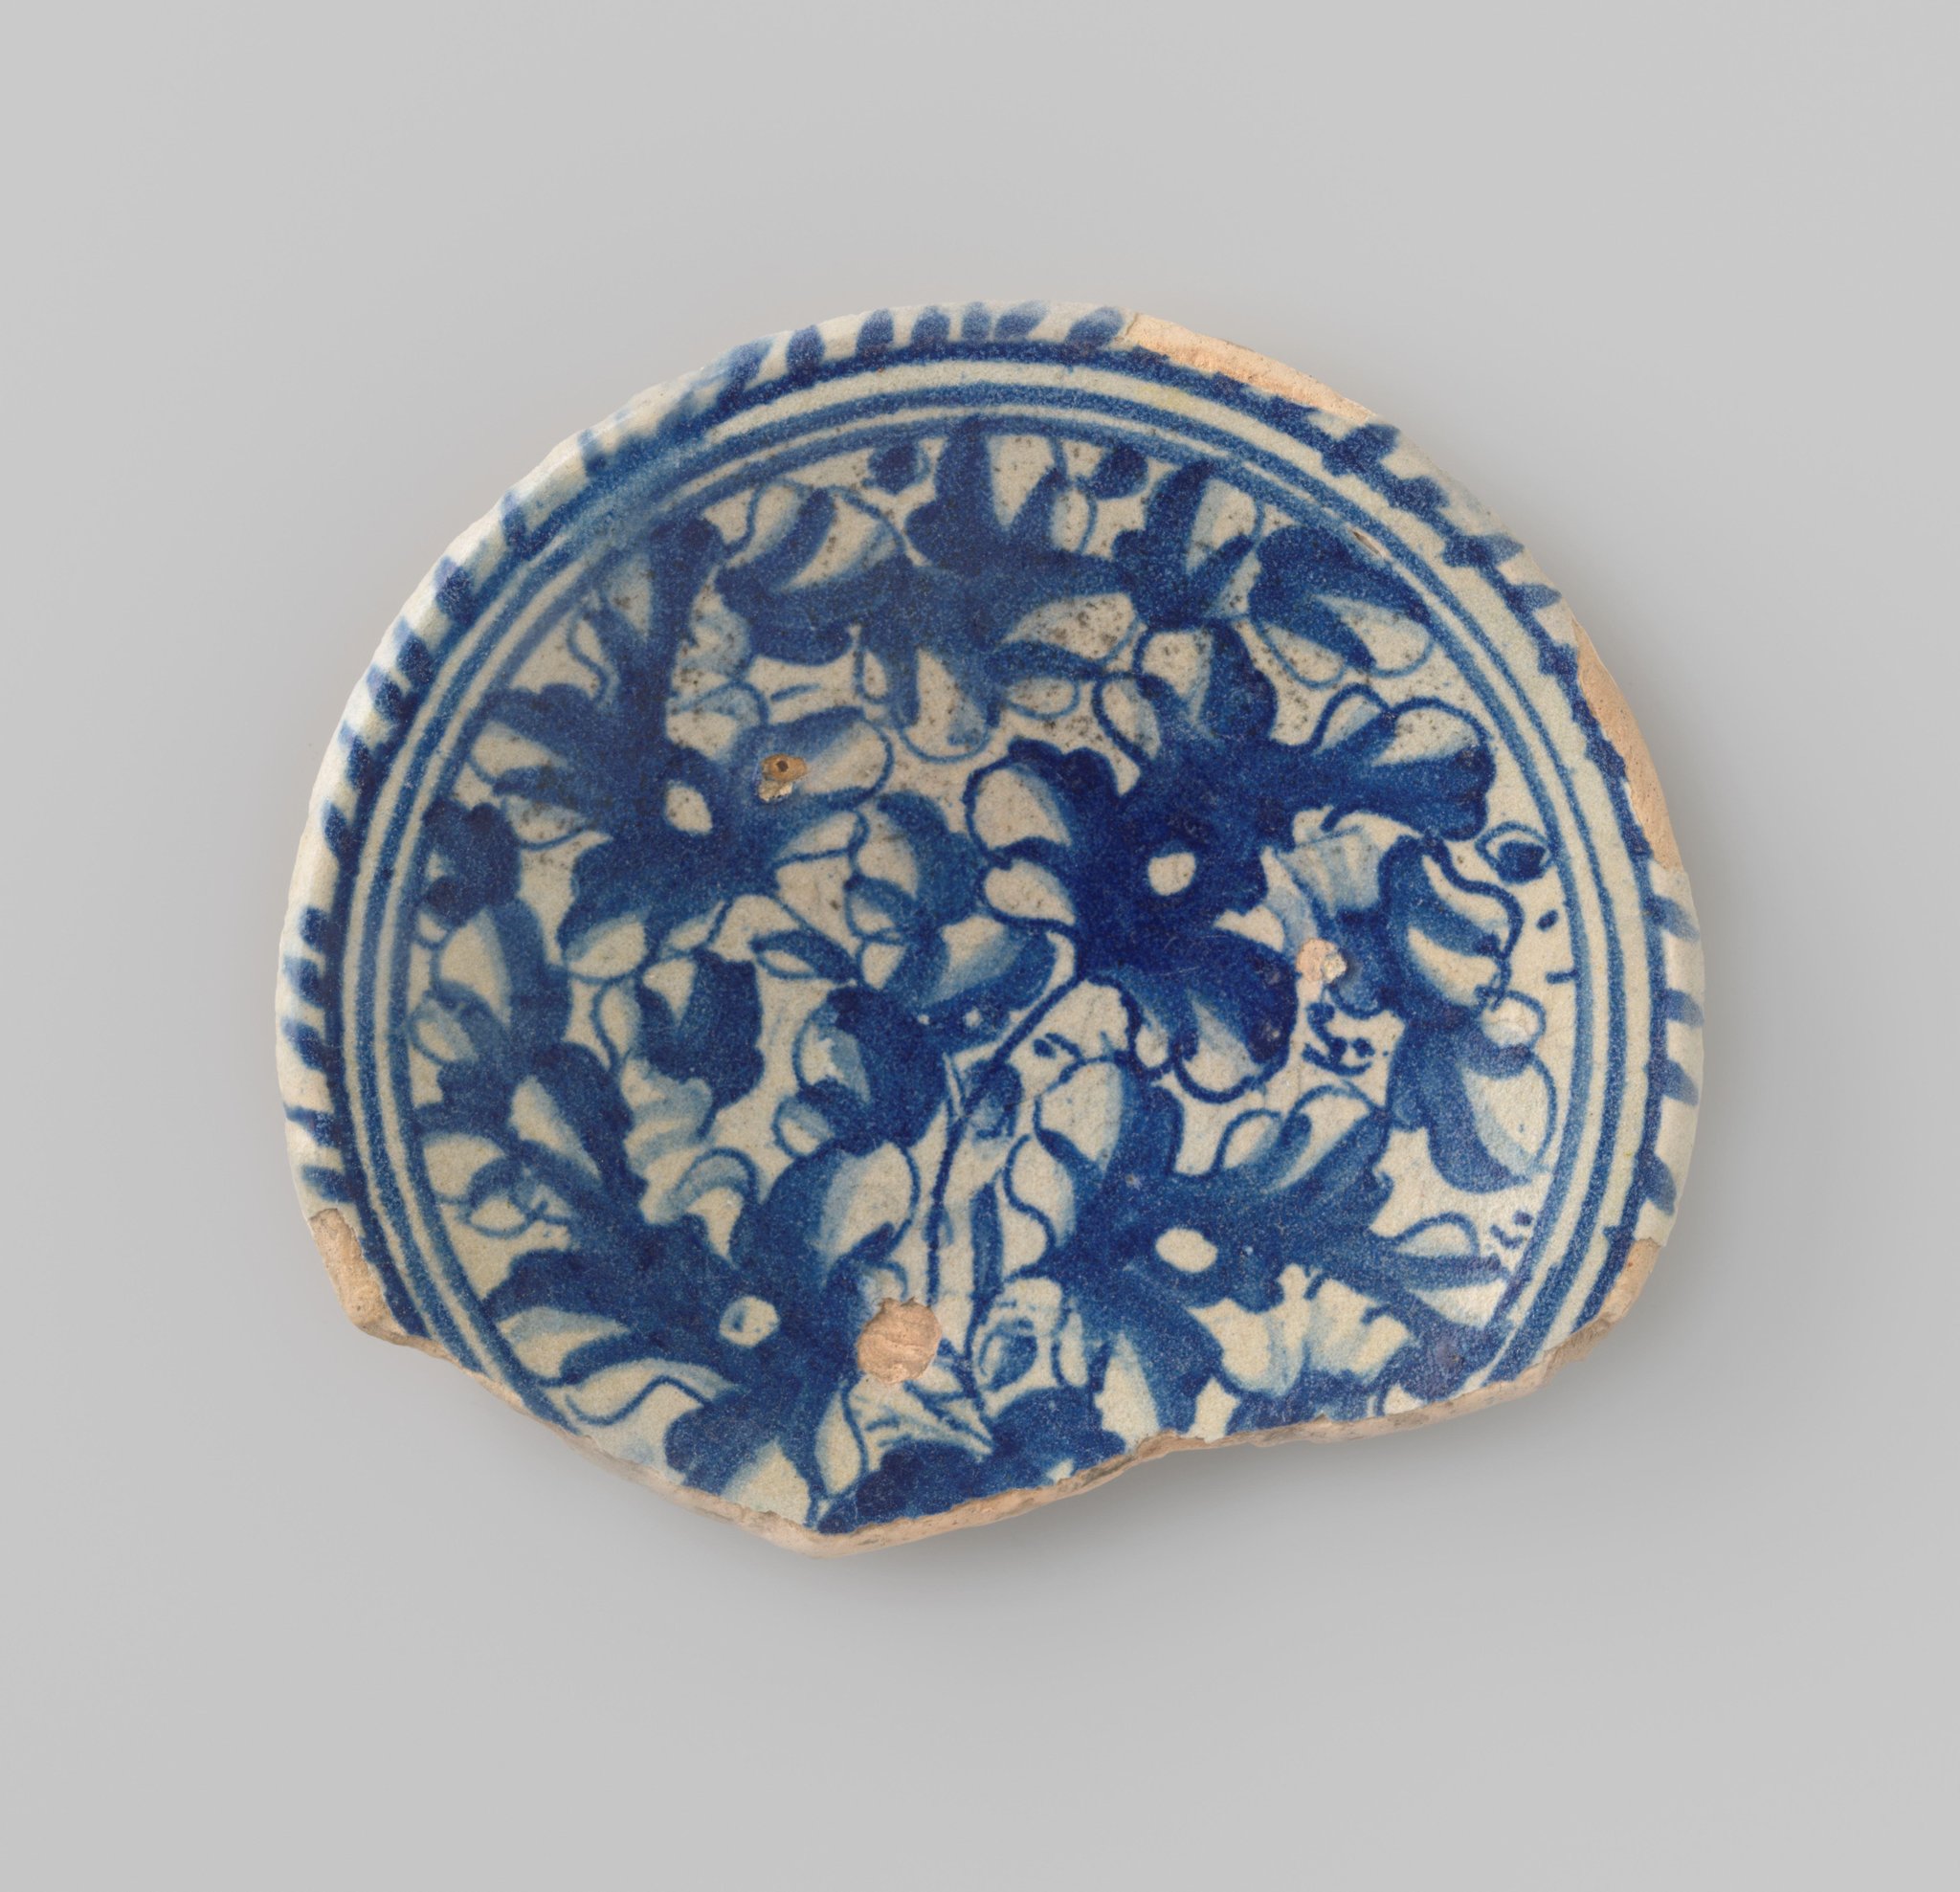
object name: platter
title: Schotel, beschilderd in blauw met bladeren.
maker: Anonymous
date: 1590-1620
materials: earthenware, glaze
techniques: maiolica, painted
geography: netherlands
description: Ronde schotel van blauw beschilderd majolica, versierd met blauwe bladeren.